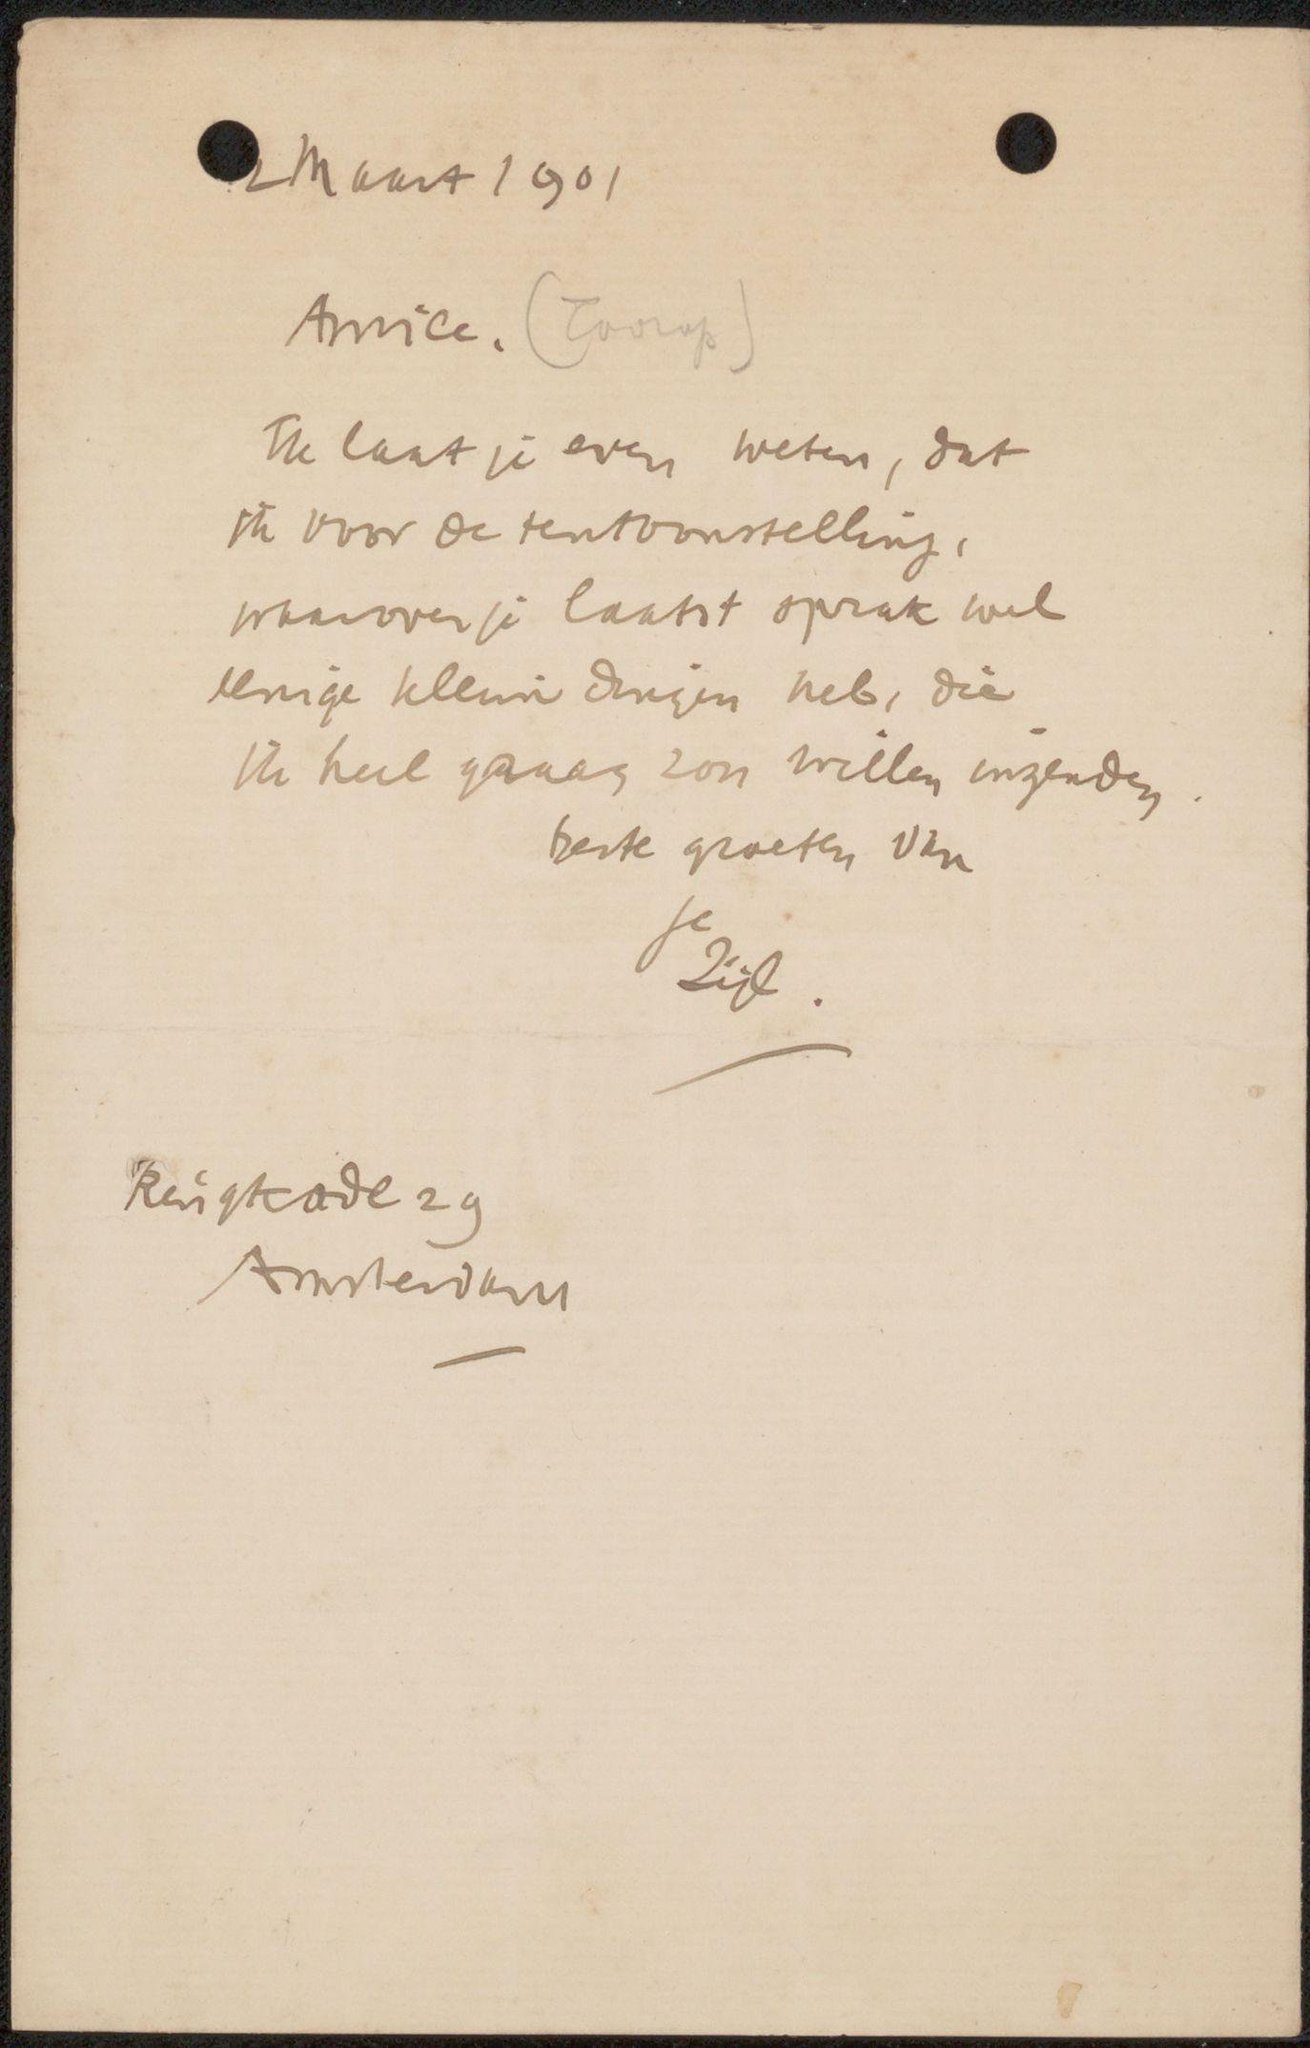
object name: letter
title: Brief aan Philip Zilcken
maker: jan toorop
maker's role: draughtsman, painter, print maker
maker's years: 1858-1928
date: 1901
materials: ink, paper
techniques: pen, writing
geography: amsterdam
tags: the hague, painter, draughtsman, philip zilcken, exhibition ~ art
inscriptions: watermark, collector's mark: ‘RPK’